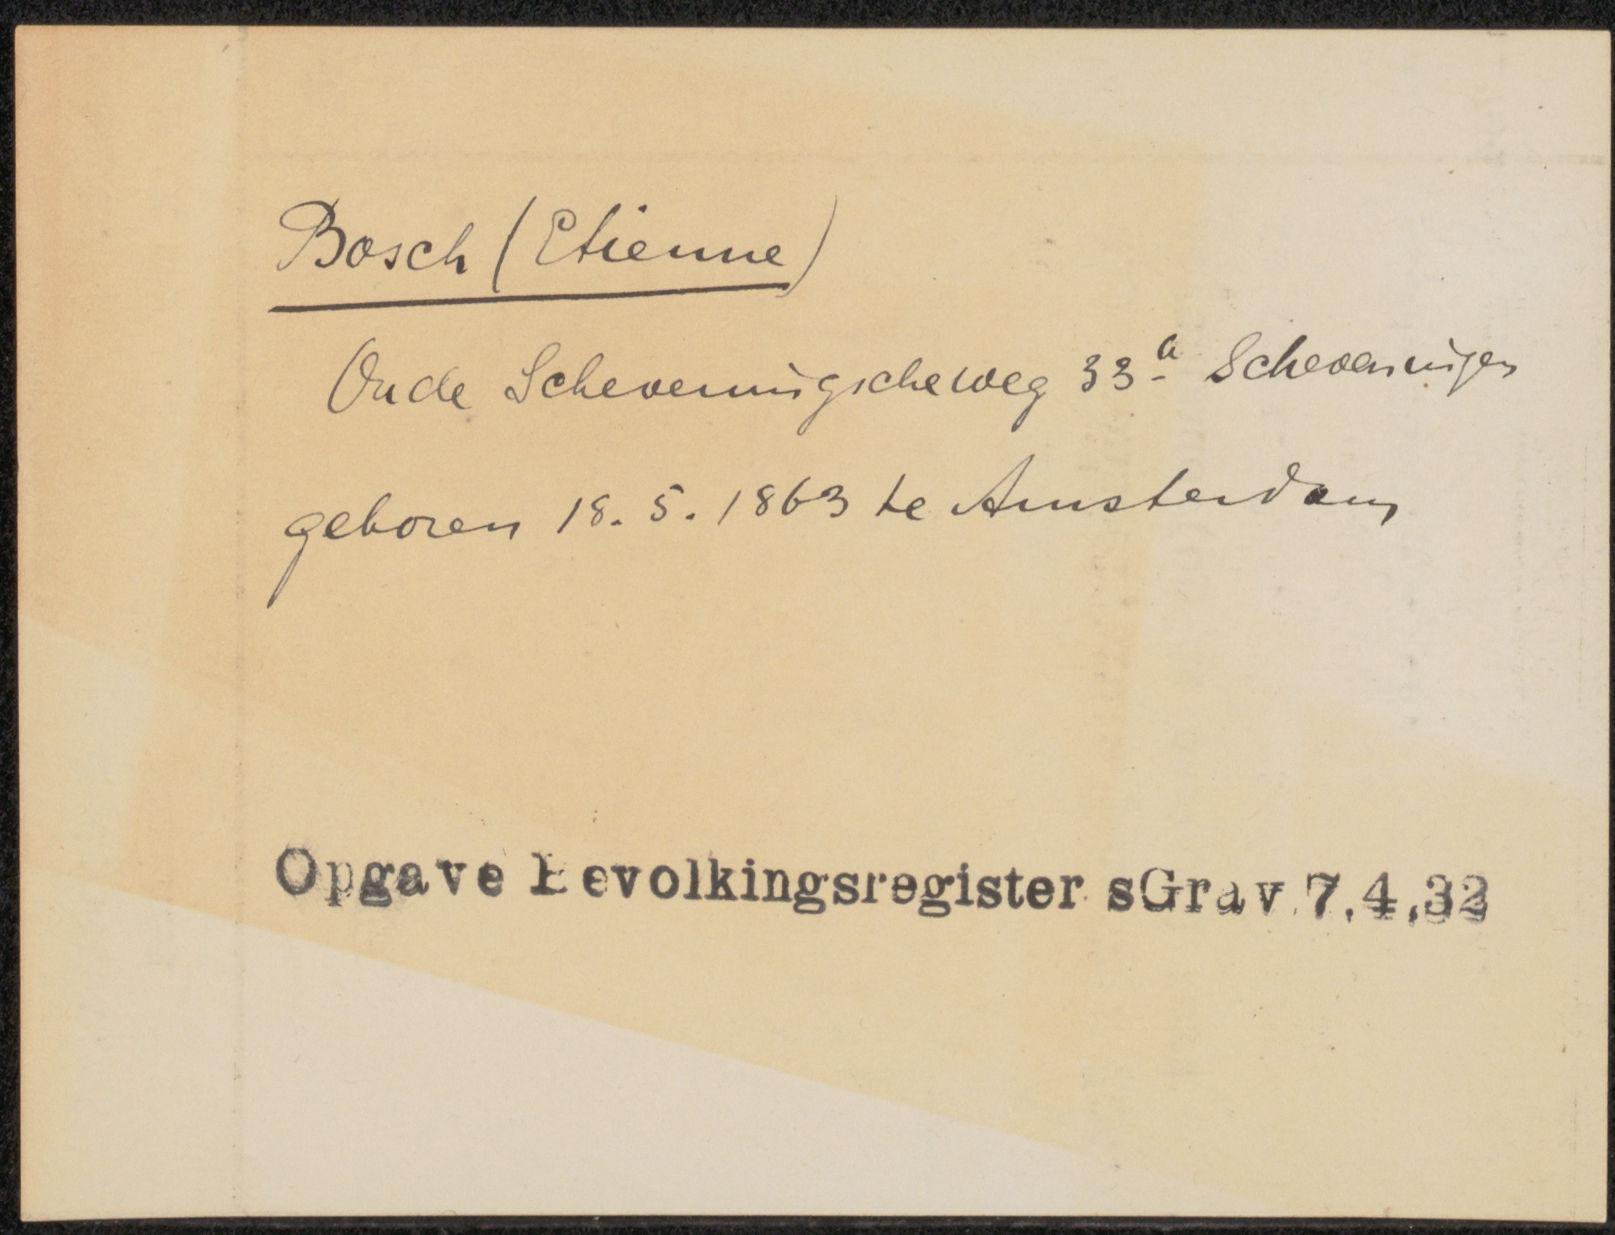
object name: document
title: Document betreffende Etienne Bosch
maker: Anonymous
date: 1932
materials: ink, paper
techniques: pen, typewriting, writing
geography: the hague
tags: amsterdam, the hague, print maker, etienne bosch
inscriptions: stamp: ‘Opgave Bevolkingsregister sGrav 6.4.32’